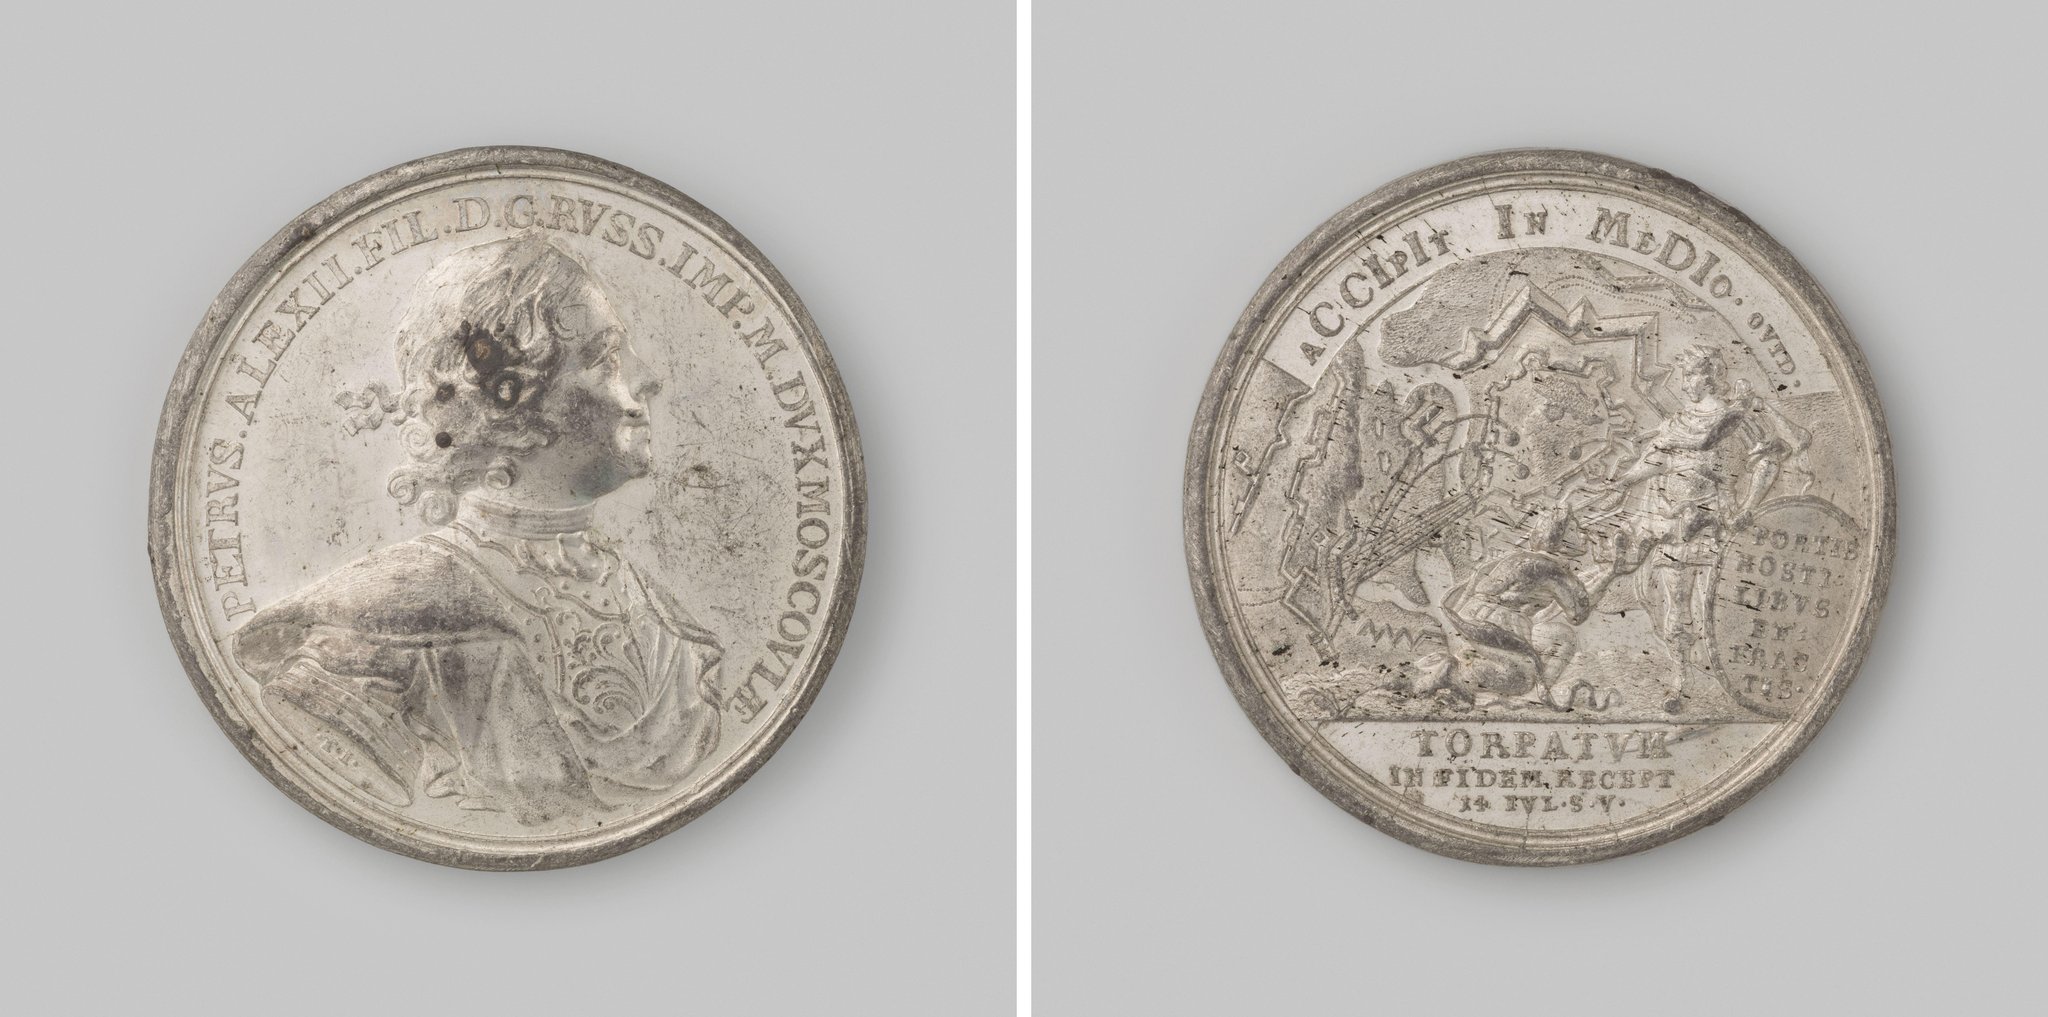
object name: history medal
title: Inname van Dorpat door Rusland op Zweden 1704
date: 1704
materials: tin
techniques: striking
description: Tinnen penning, op de voorzijde het borstbeeld van Tsaar Peter de Grote naar rechts met omschrift, op de keerzijde een vrouw die een kroon aanbiedt aan Tsaar Peter met op de achtergrond een pattegrnd van het bombardement van Dorpat, met omschrift en afsnedetekst.